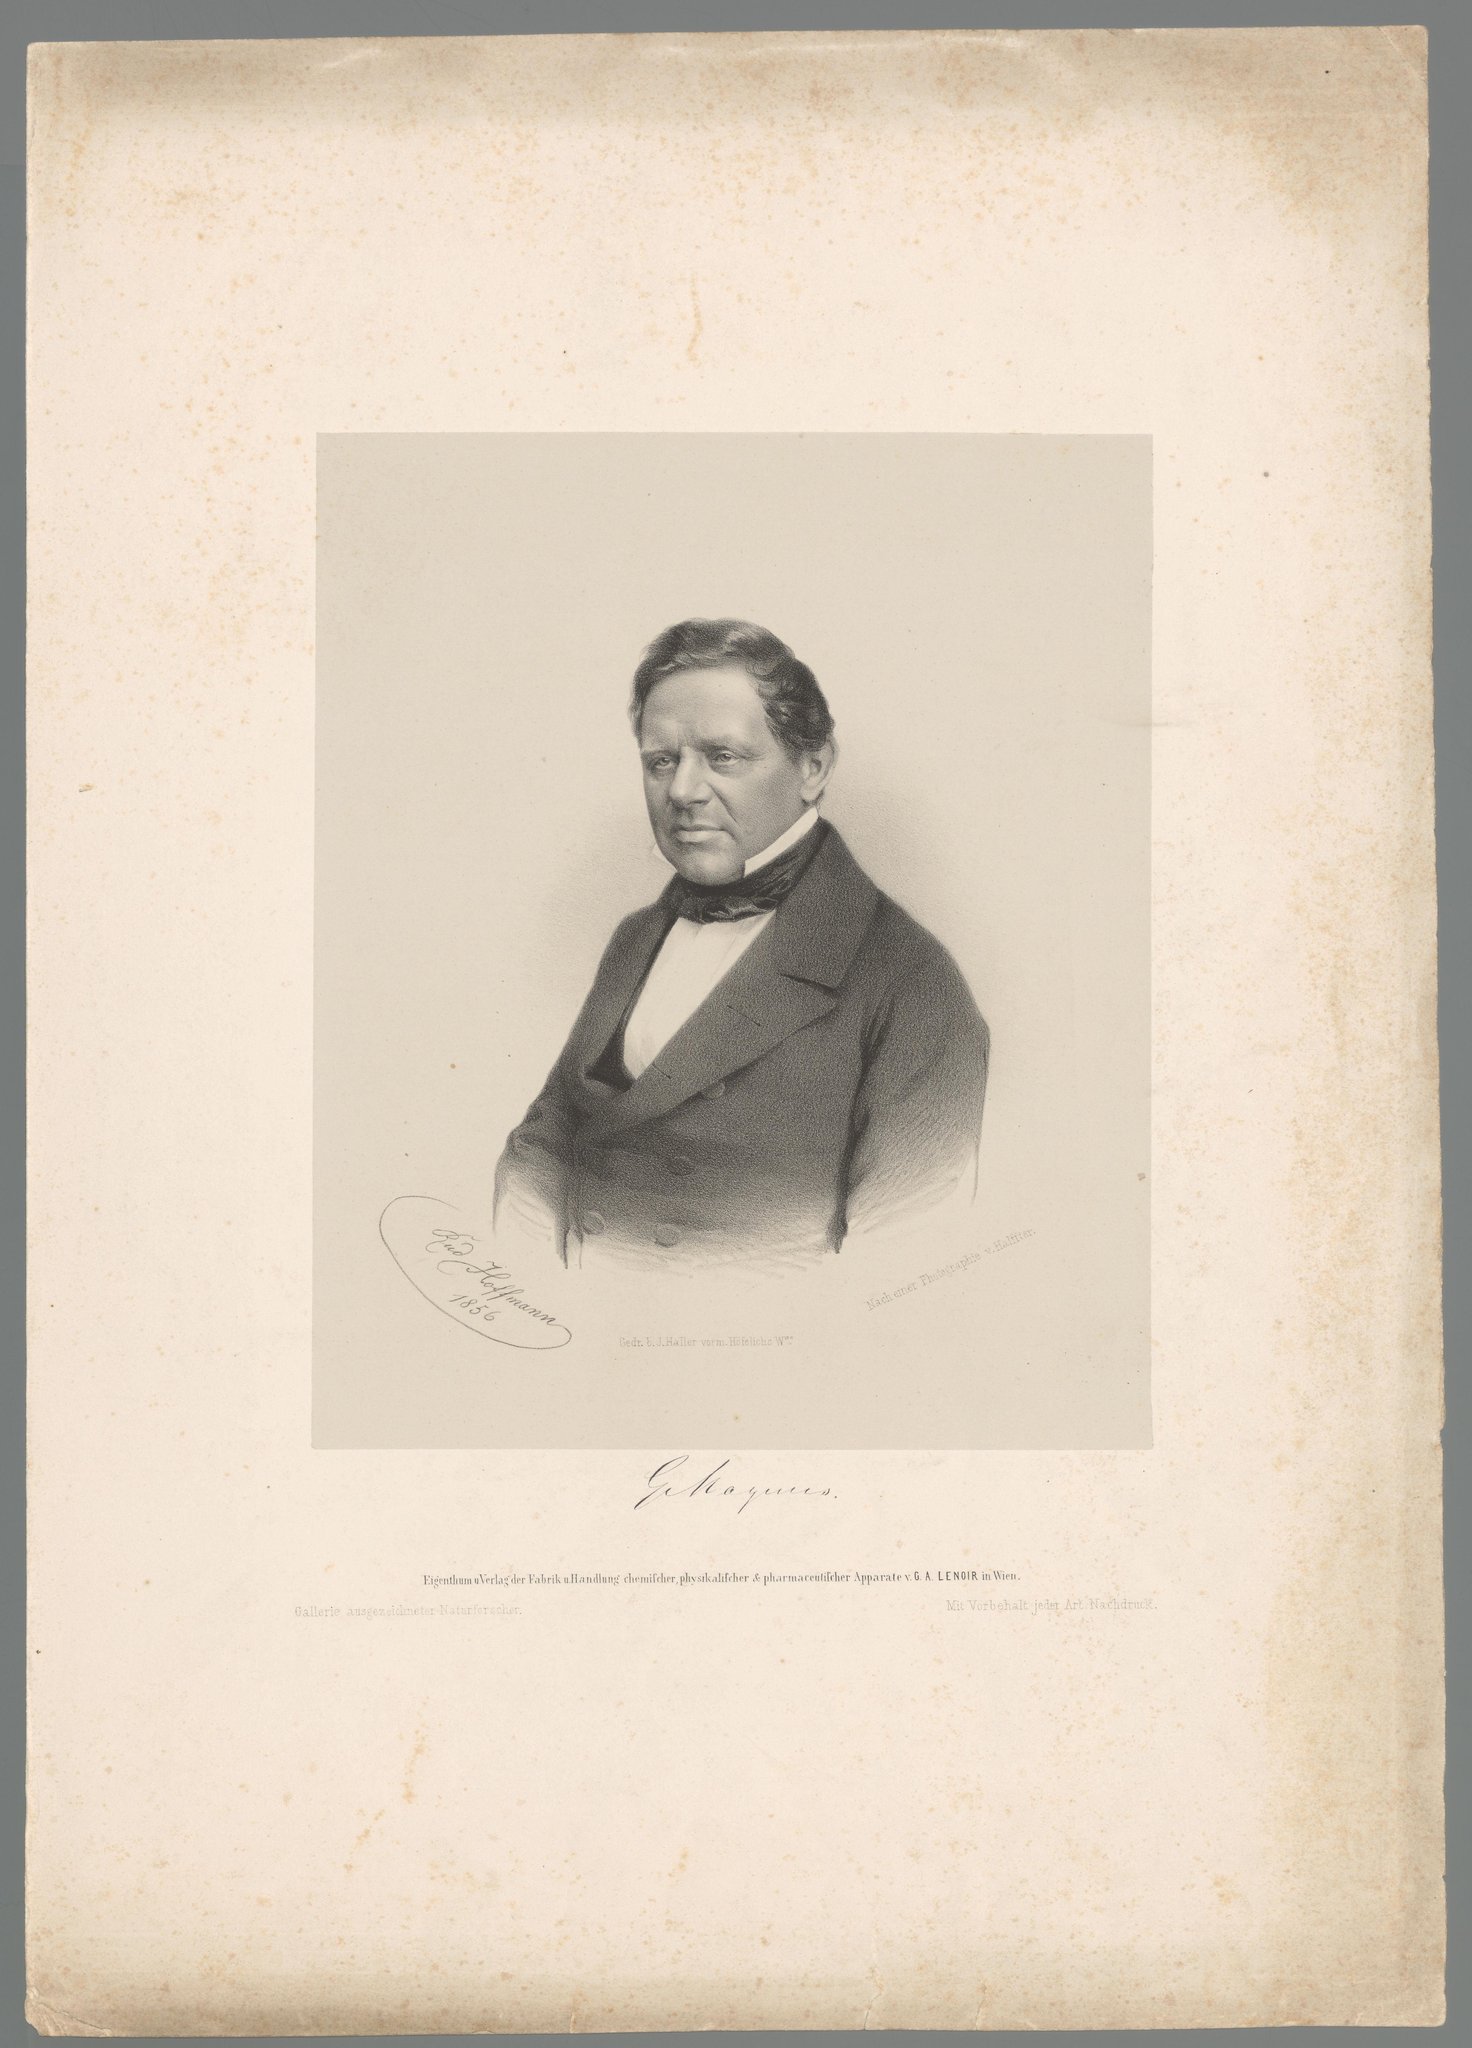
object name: print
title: Portret van Heinrich Gustav Magnus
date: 1856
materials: paper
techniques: lithograph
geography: vienna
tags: adult man, historical persons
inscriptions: collector's mark: Lugt 2228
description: Deze prent behoort tot een serie met 100 portretten van natuurwetenschappers, uitgegeven tussen 1856-1860.